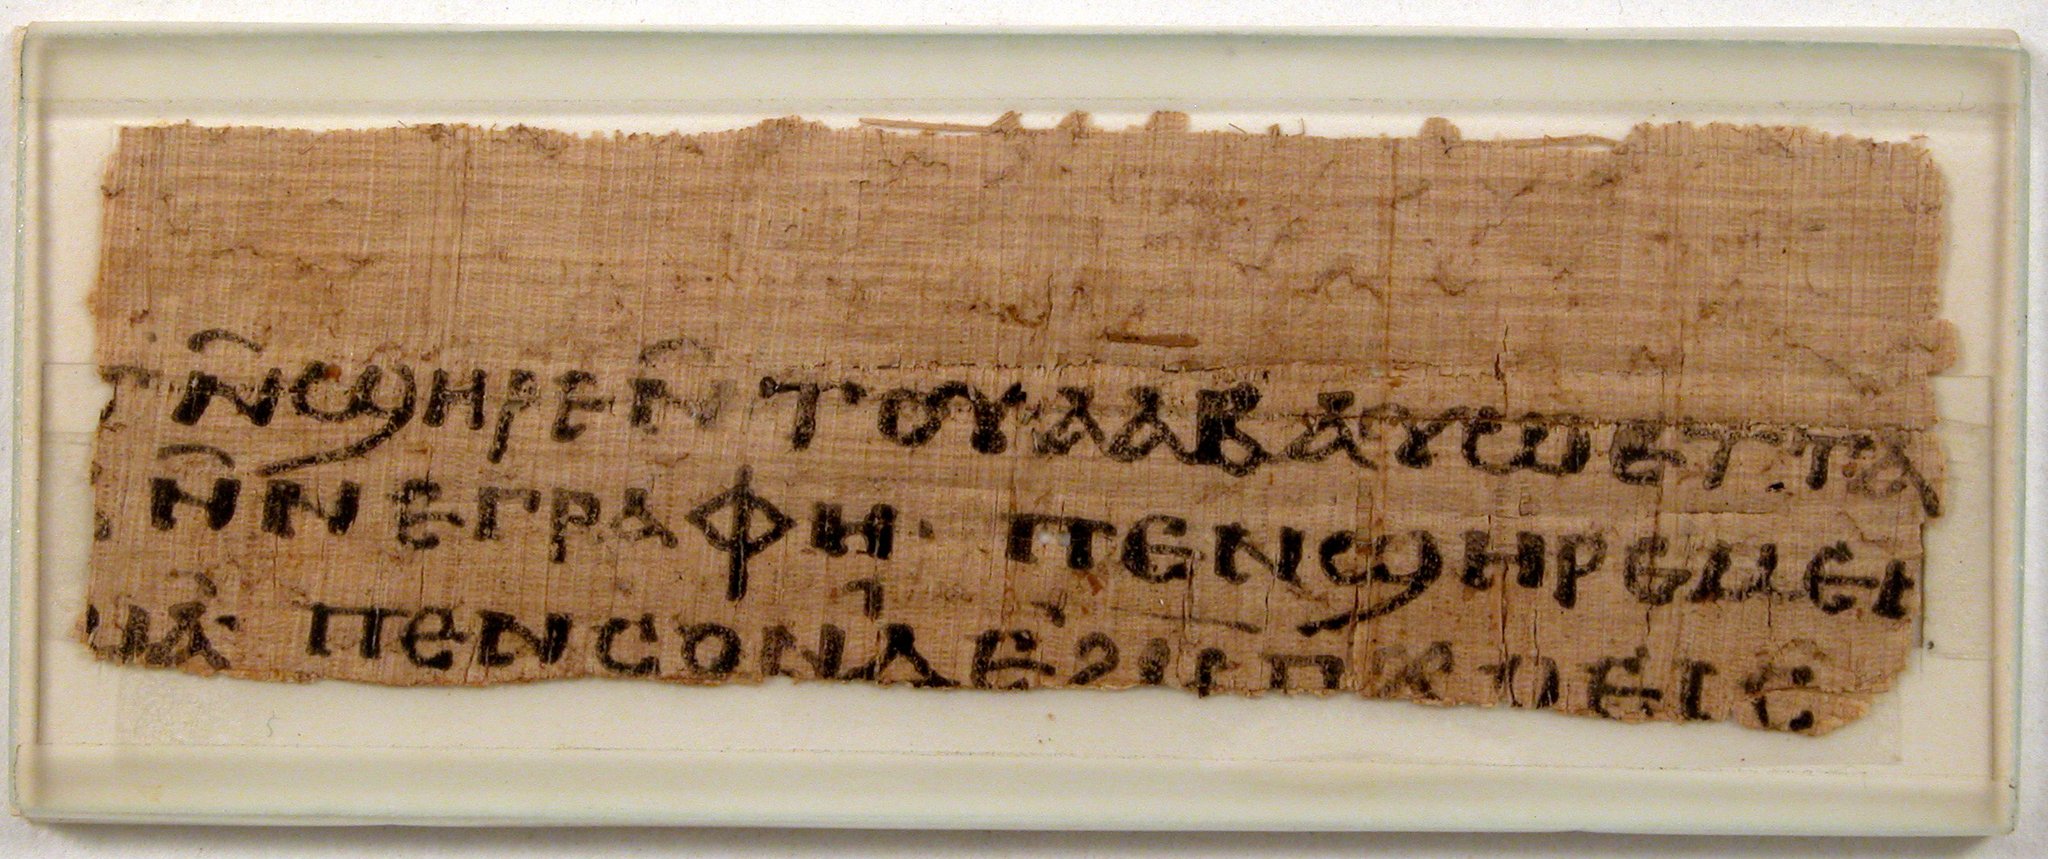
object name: fragment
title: Papyrus Fragment of a Letter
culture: coptic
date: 601-700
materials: ink, papyrus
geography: egypt